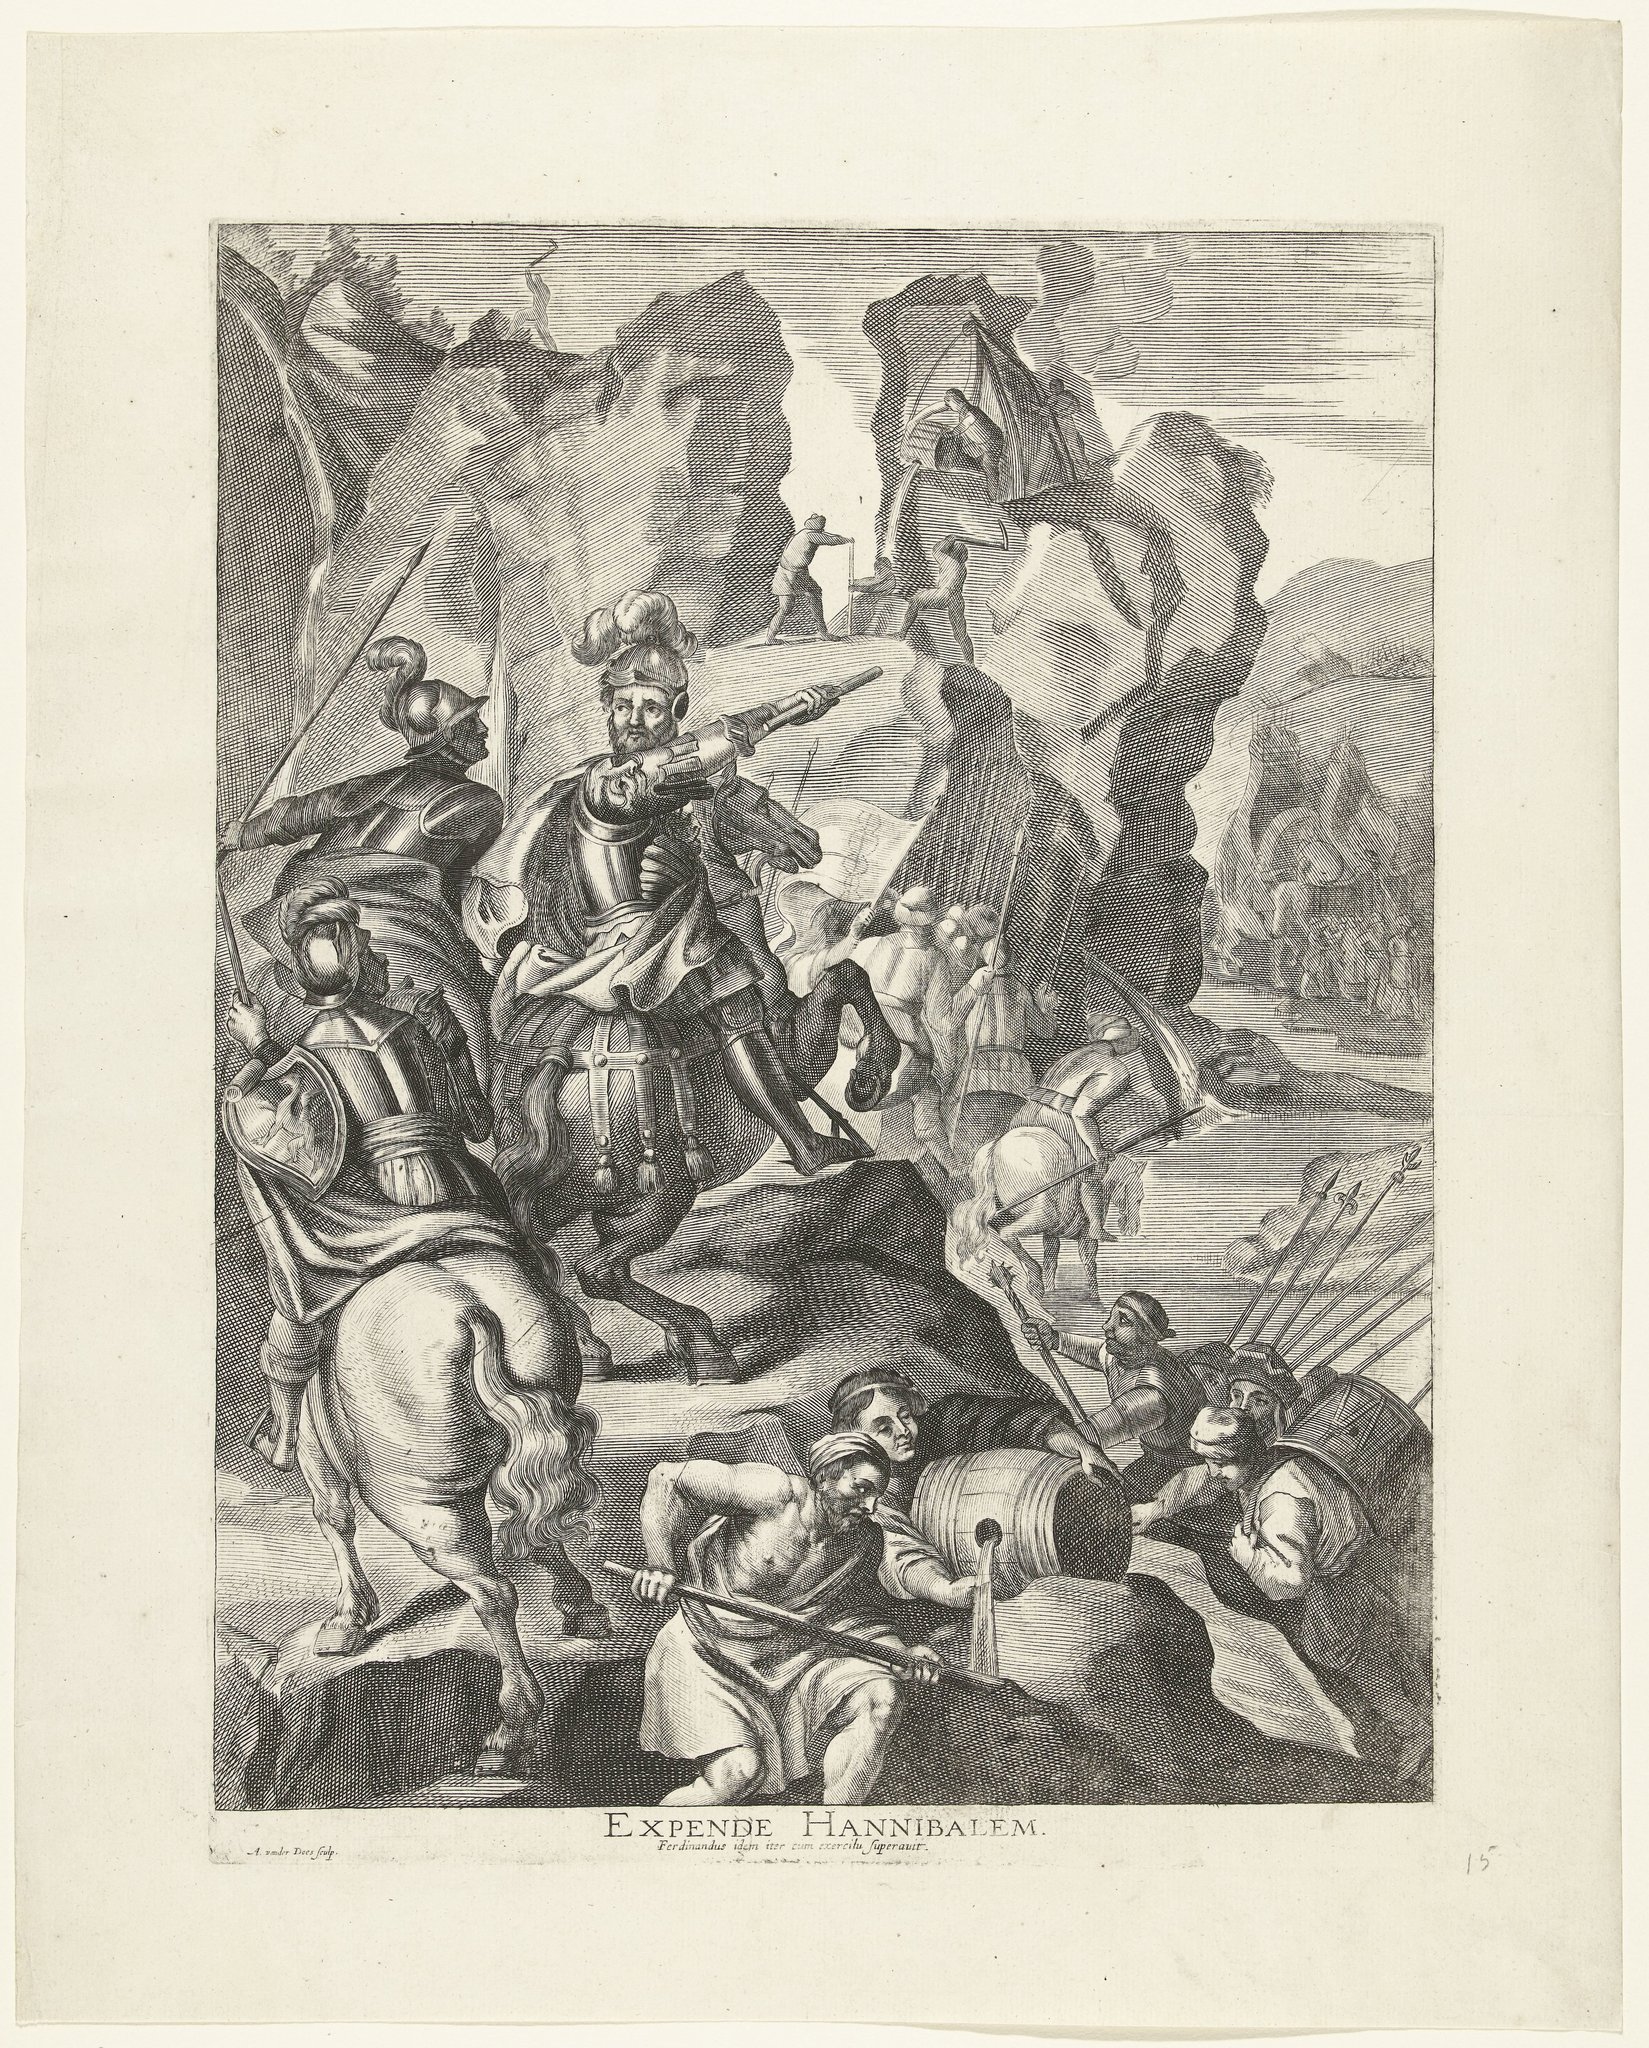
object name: history print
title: Tabula III. Hannibal cum exercitu Alpes transmittit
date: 1635-1636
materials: paper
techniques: engraving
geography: southern netherlands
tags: brussels, landvoogd der zuidelijke nederlanden ferdinand van oostenrijk, triumphal arch, hannibal crosses the alps with his army and his elephants, ghent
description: Hannibal steekt het zijn leger de Alpen over (218 v.Chr.), zoals later Ferdinand ook zou doen. Voorstelling linksboven op de achterzijde van de triomfpoort Arcus Fernandi op de Vrijdagmarkt. Blad nr. 15 in een geheel van 42 platen die de uitgave van de beschrijving van de intocht van de Kardinaal Infant Ferdinand van Oostenrijk te Gent op 28 januari 1635 als de nieuwe landvoogd voor de Spaanse Nederlanden illustreren.